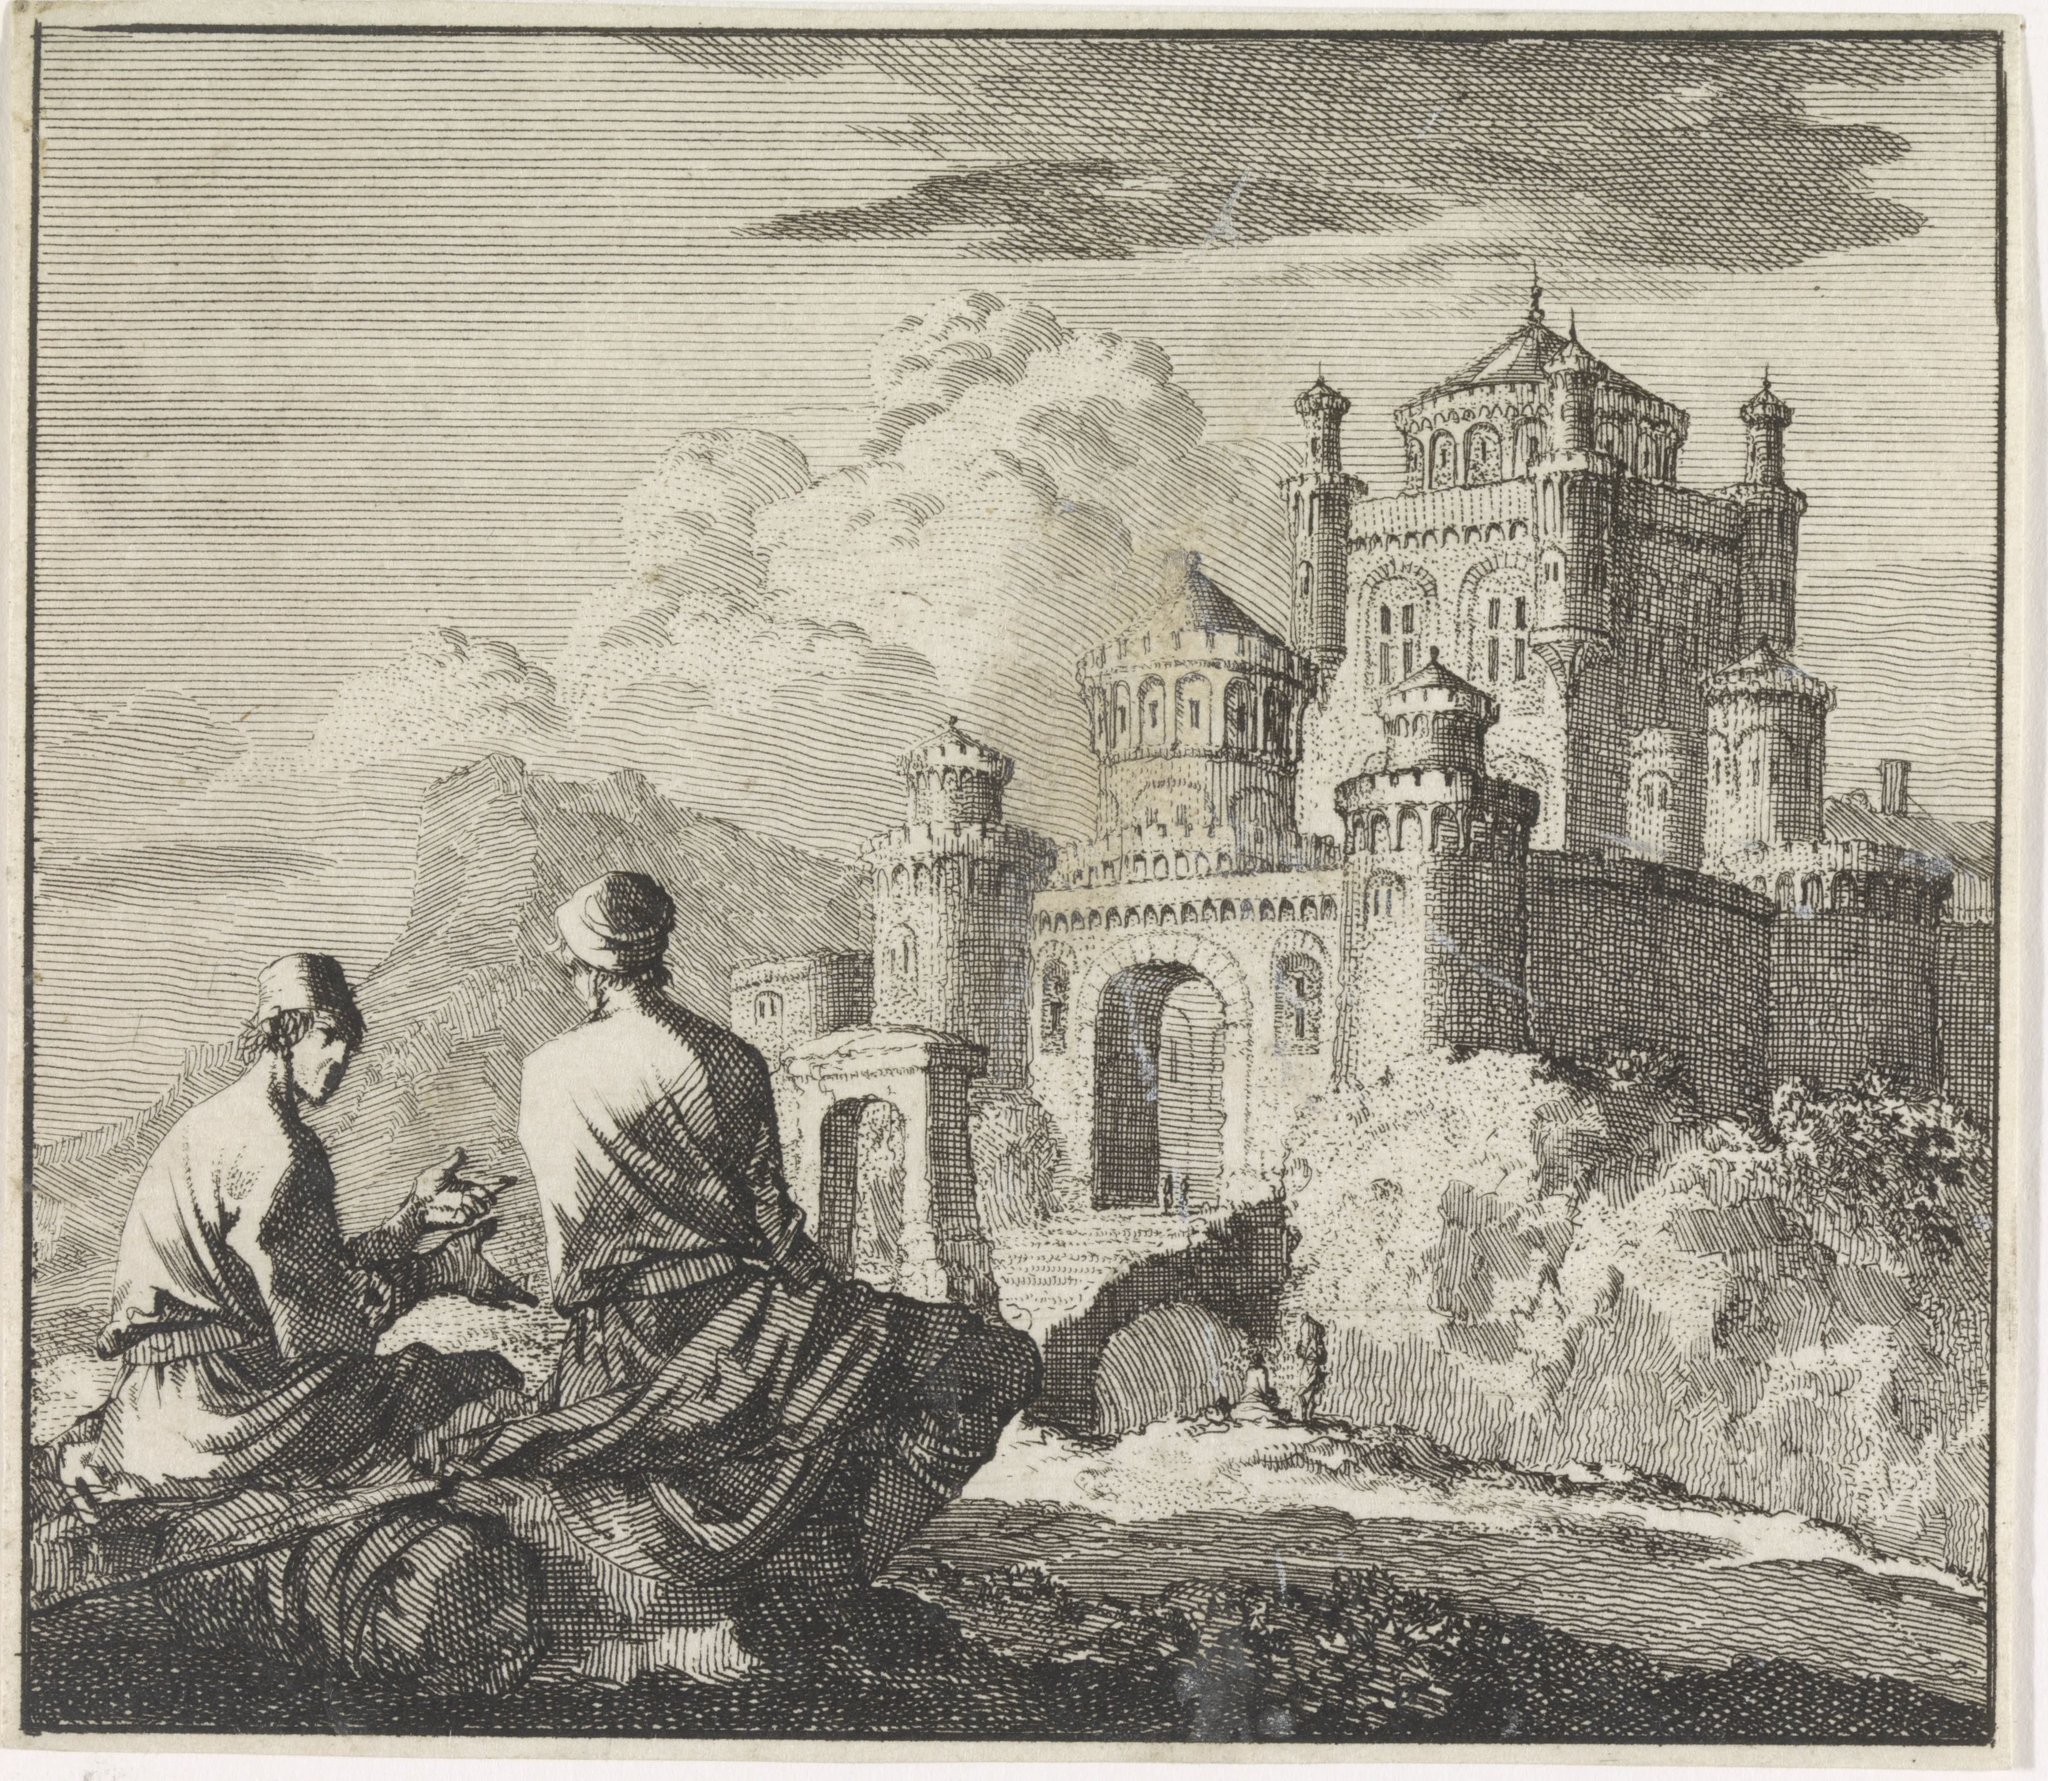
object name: book illustration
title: Embleem: burcht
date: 1695-1705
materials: paper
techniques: etching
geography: nuremberg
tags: fortress, 'en route', traveller under way, abstract ideas and concepts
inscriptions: collector's mark: Lugt 240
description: Boekillustratie voor Weigel, Christoph. Ethica Naturalis seu Documenta Moralia e Variis rerum Naturalium proprietatibus Virtutum Vitiorumq symbolicis imaginibus collecta. Neurenberg: Christoph Weigel: c. 1700.